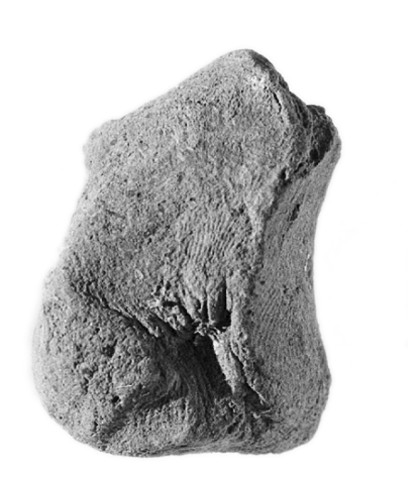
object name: sealing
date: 1981-1640 BCE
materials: mud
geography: egypt